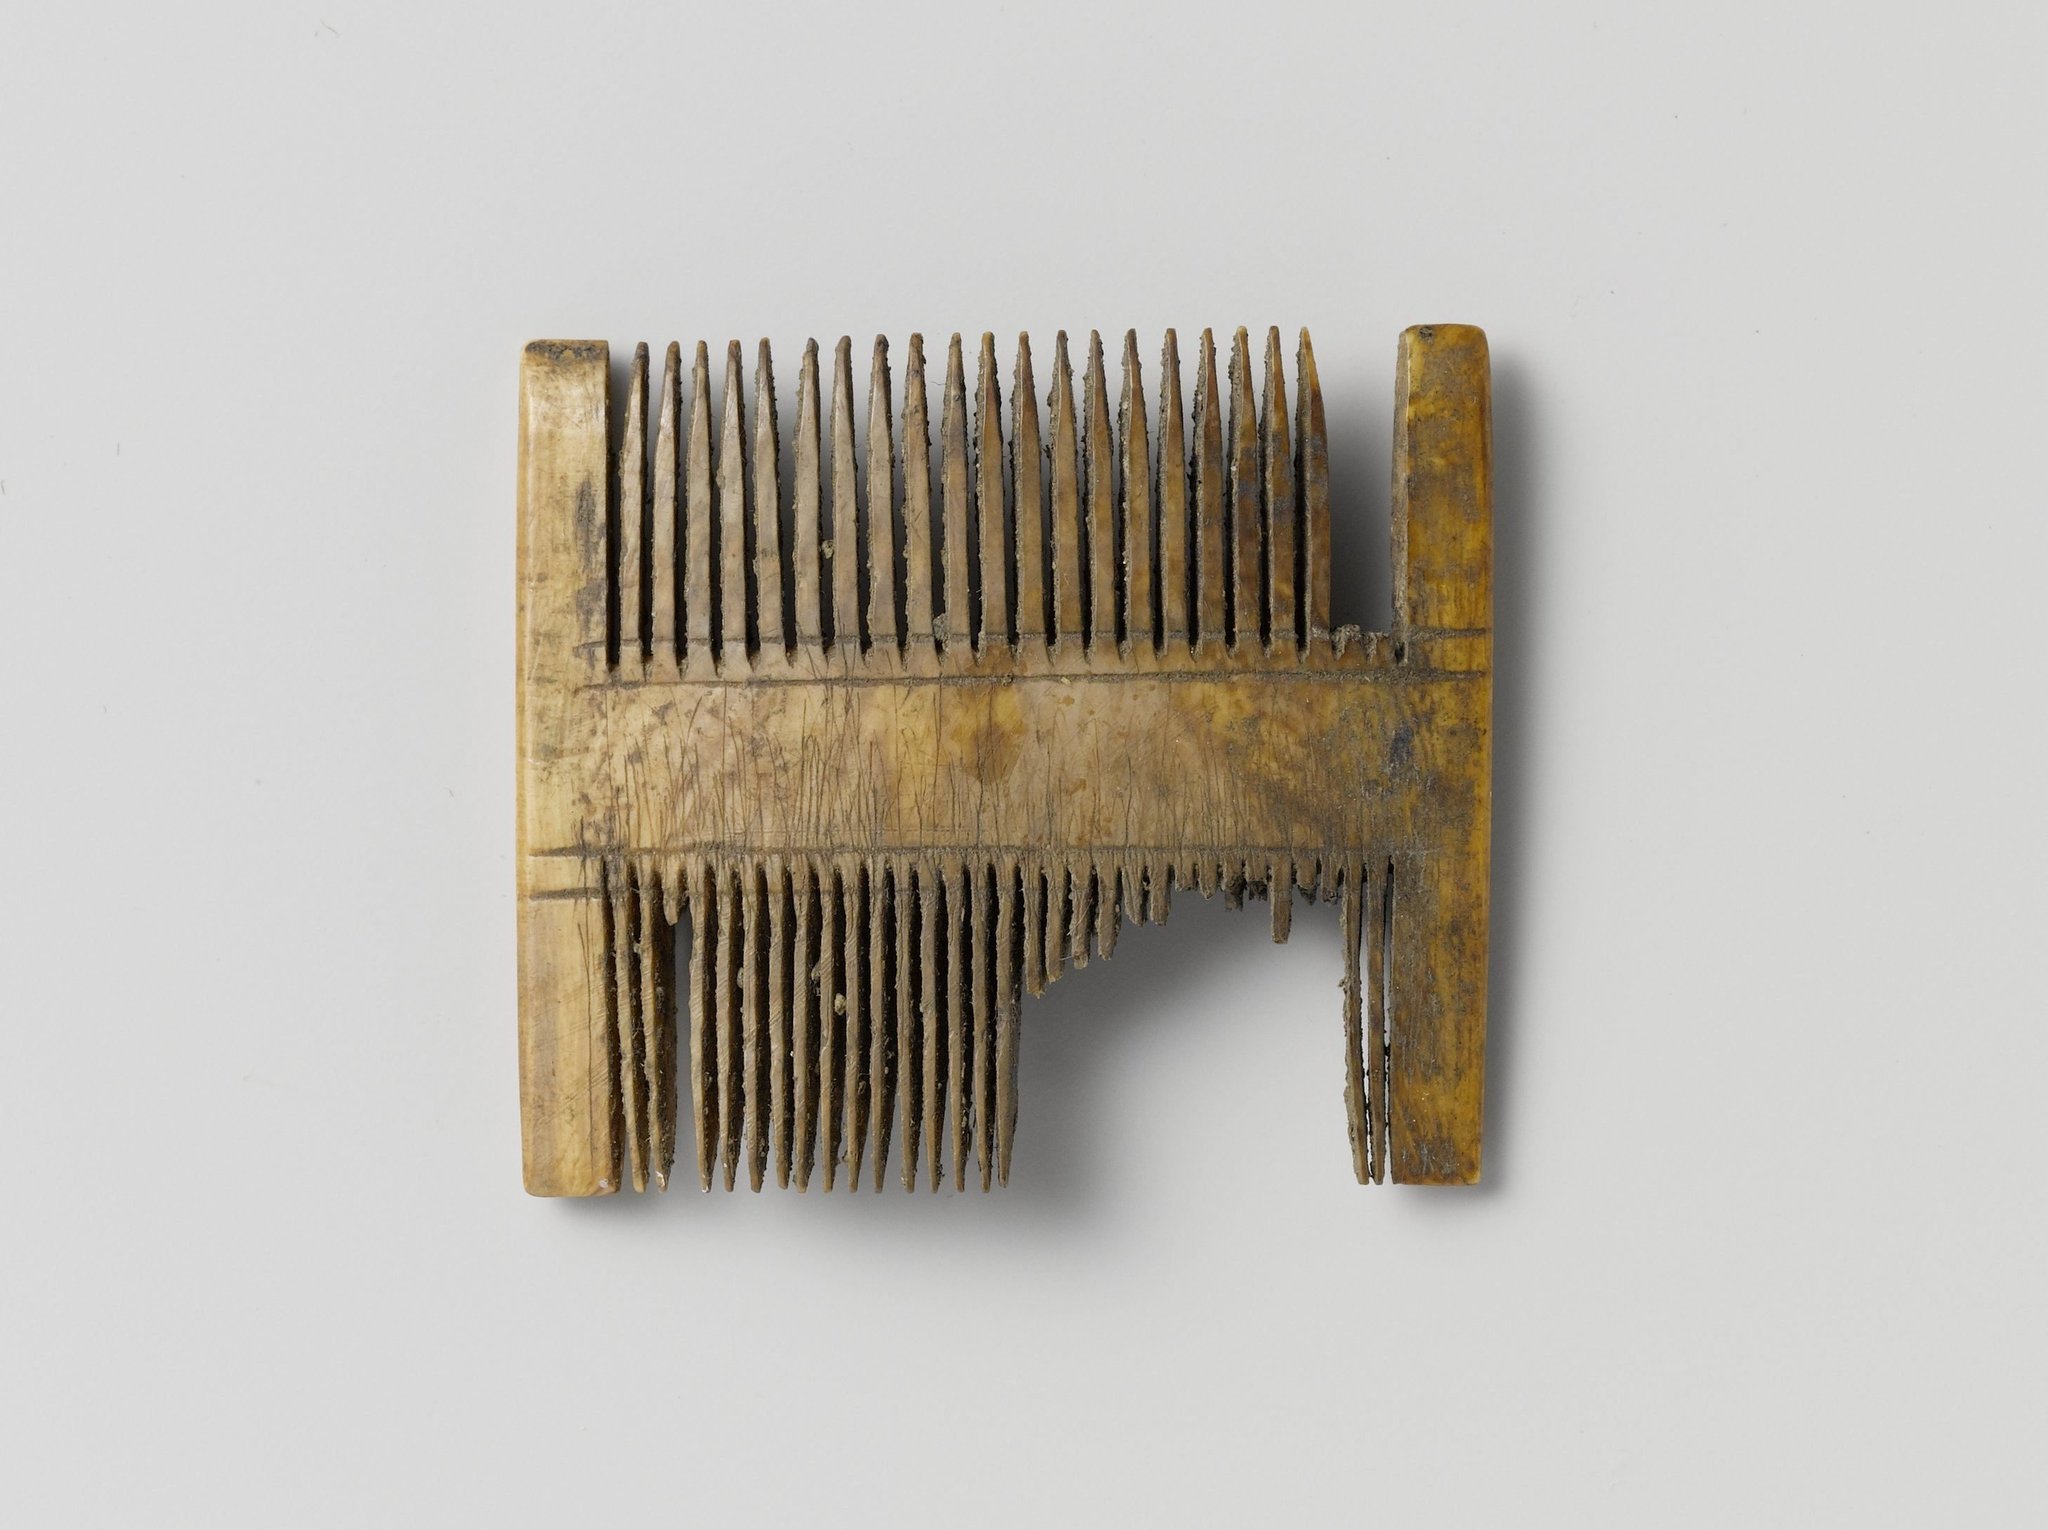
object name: comb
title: Personal effects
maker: Anonymous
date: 1590-1596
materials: wood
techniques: sawing, sewing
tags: willem barendsz., amsterdam, jacob van heemskerck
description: Each crewman had his own sea chest for his personal belongings. These wooden chests have since perished, only the locks and little keys remain. To kill time, the men made music and played sports. A drumstick and a flute were found on Nova Zembla. The ball is made of whalebone and was used to play ‘kolven’, a kind of hockey. The little comb was used to remove headlice.